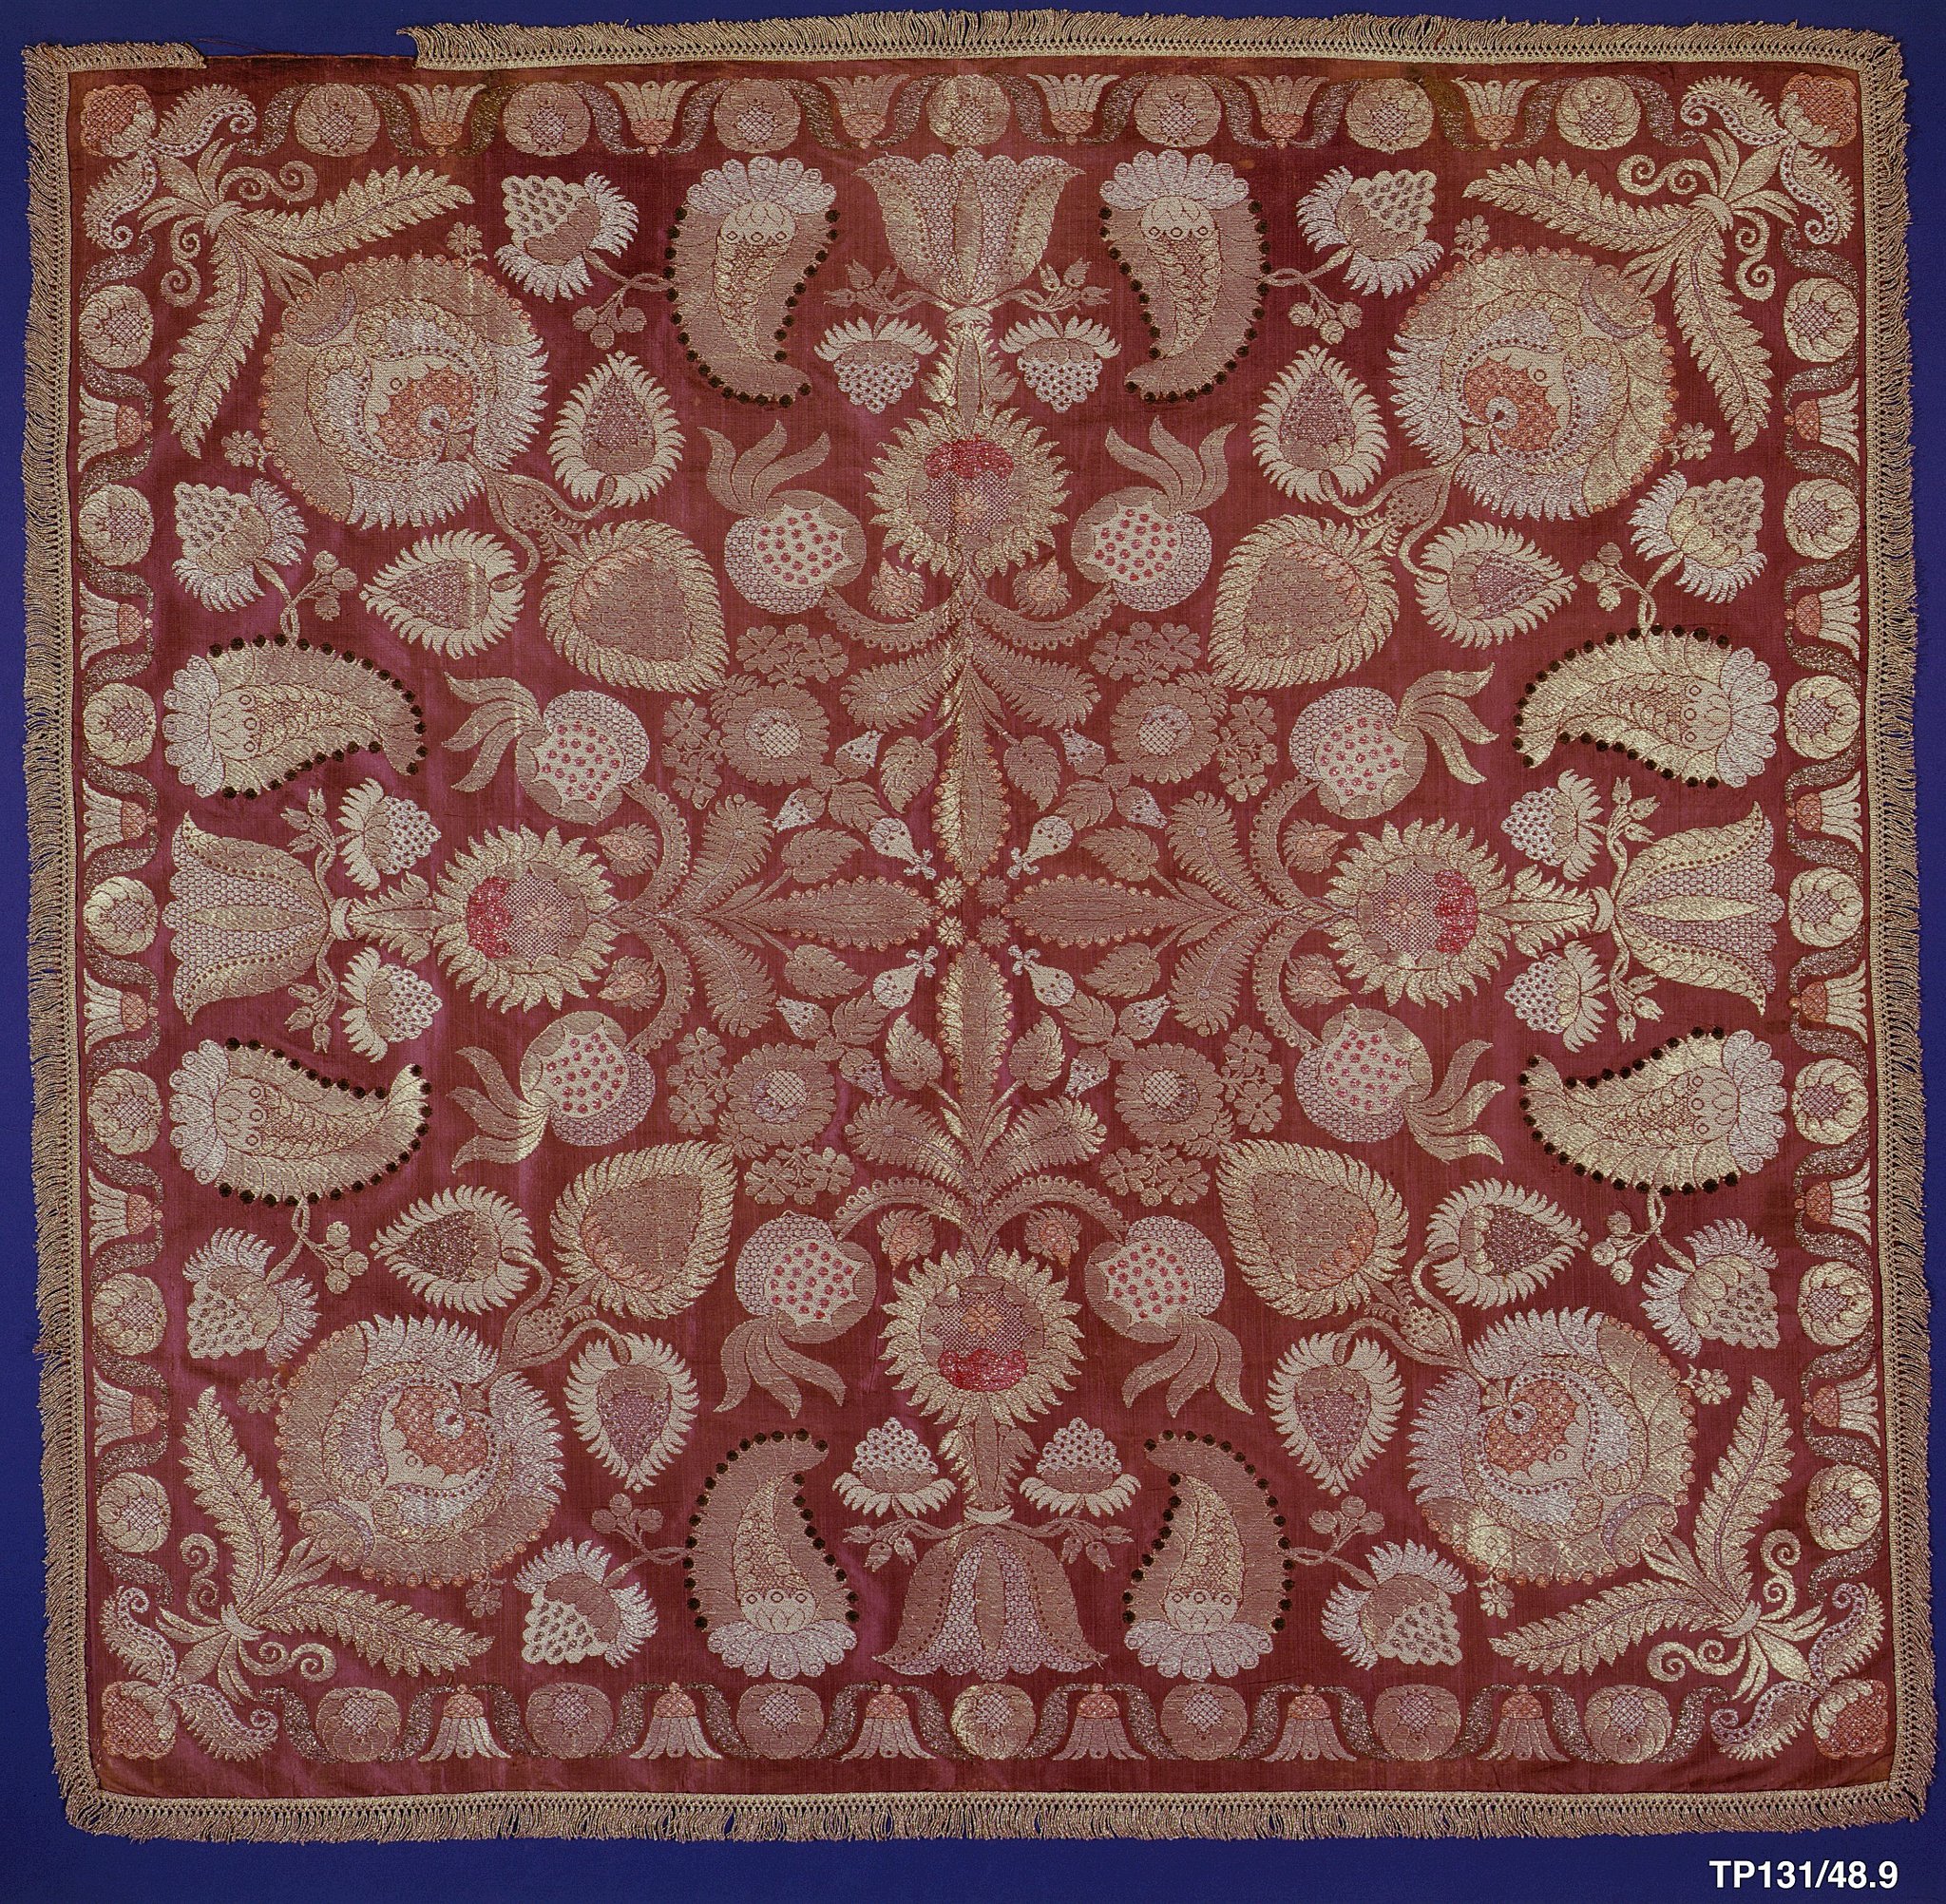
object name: square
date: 1801-1850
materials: metal thread, silk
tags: flowers